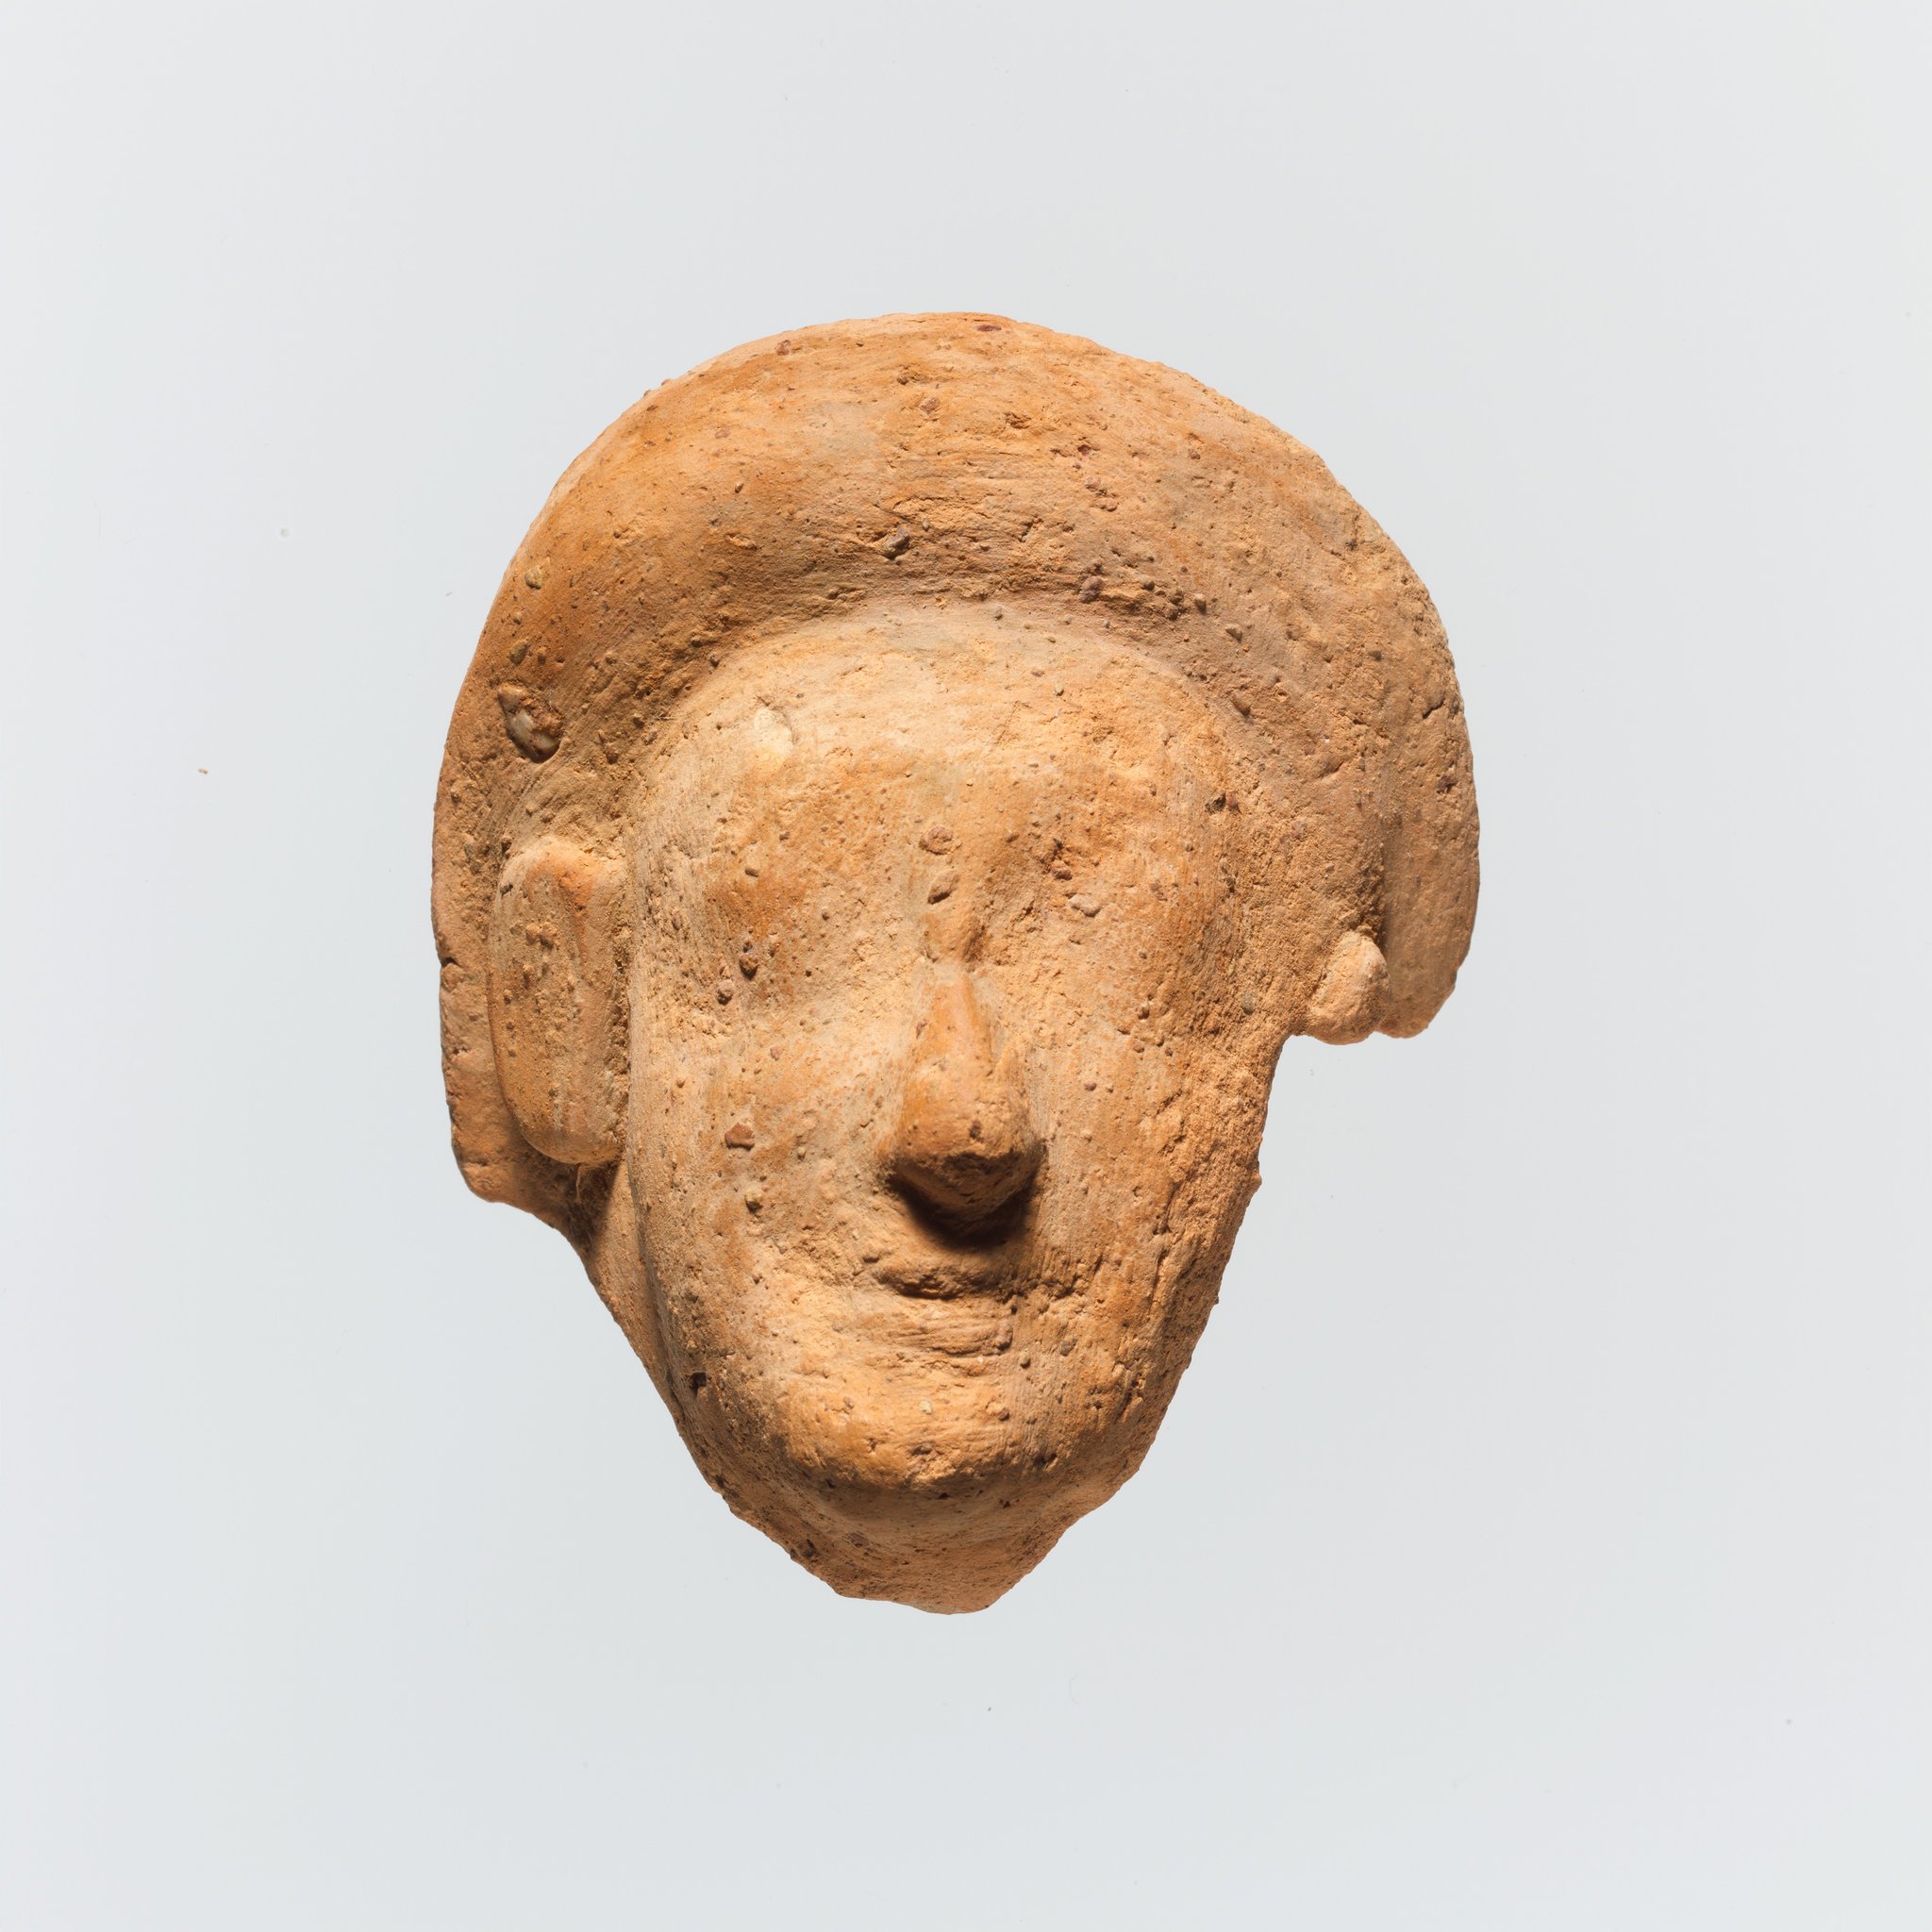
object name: mask of a woman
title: Terracotta fragment of a woman's head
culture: greek, cretan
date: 600-401 BCE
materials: terracotta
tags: heads,women